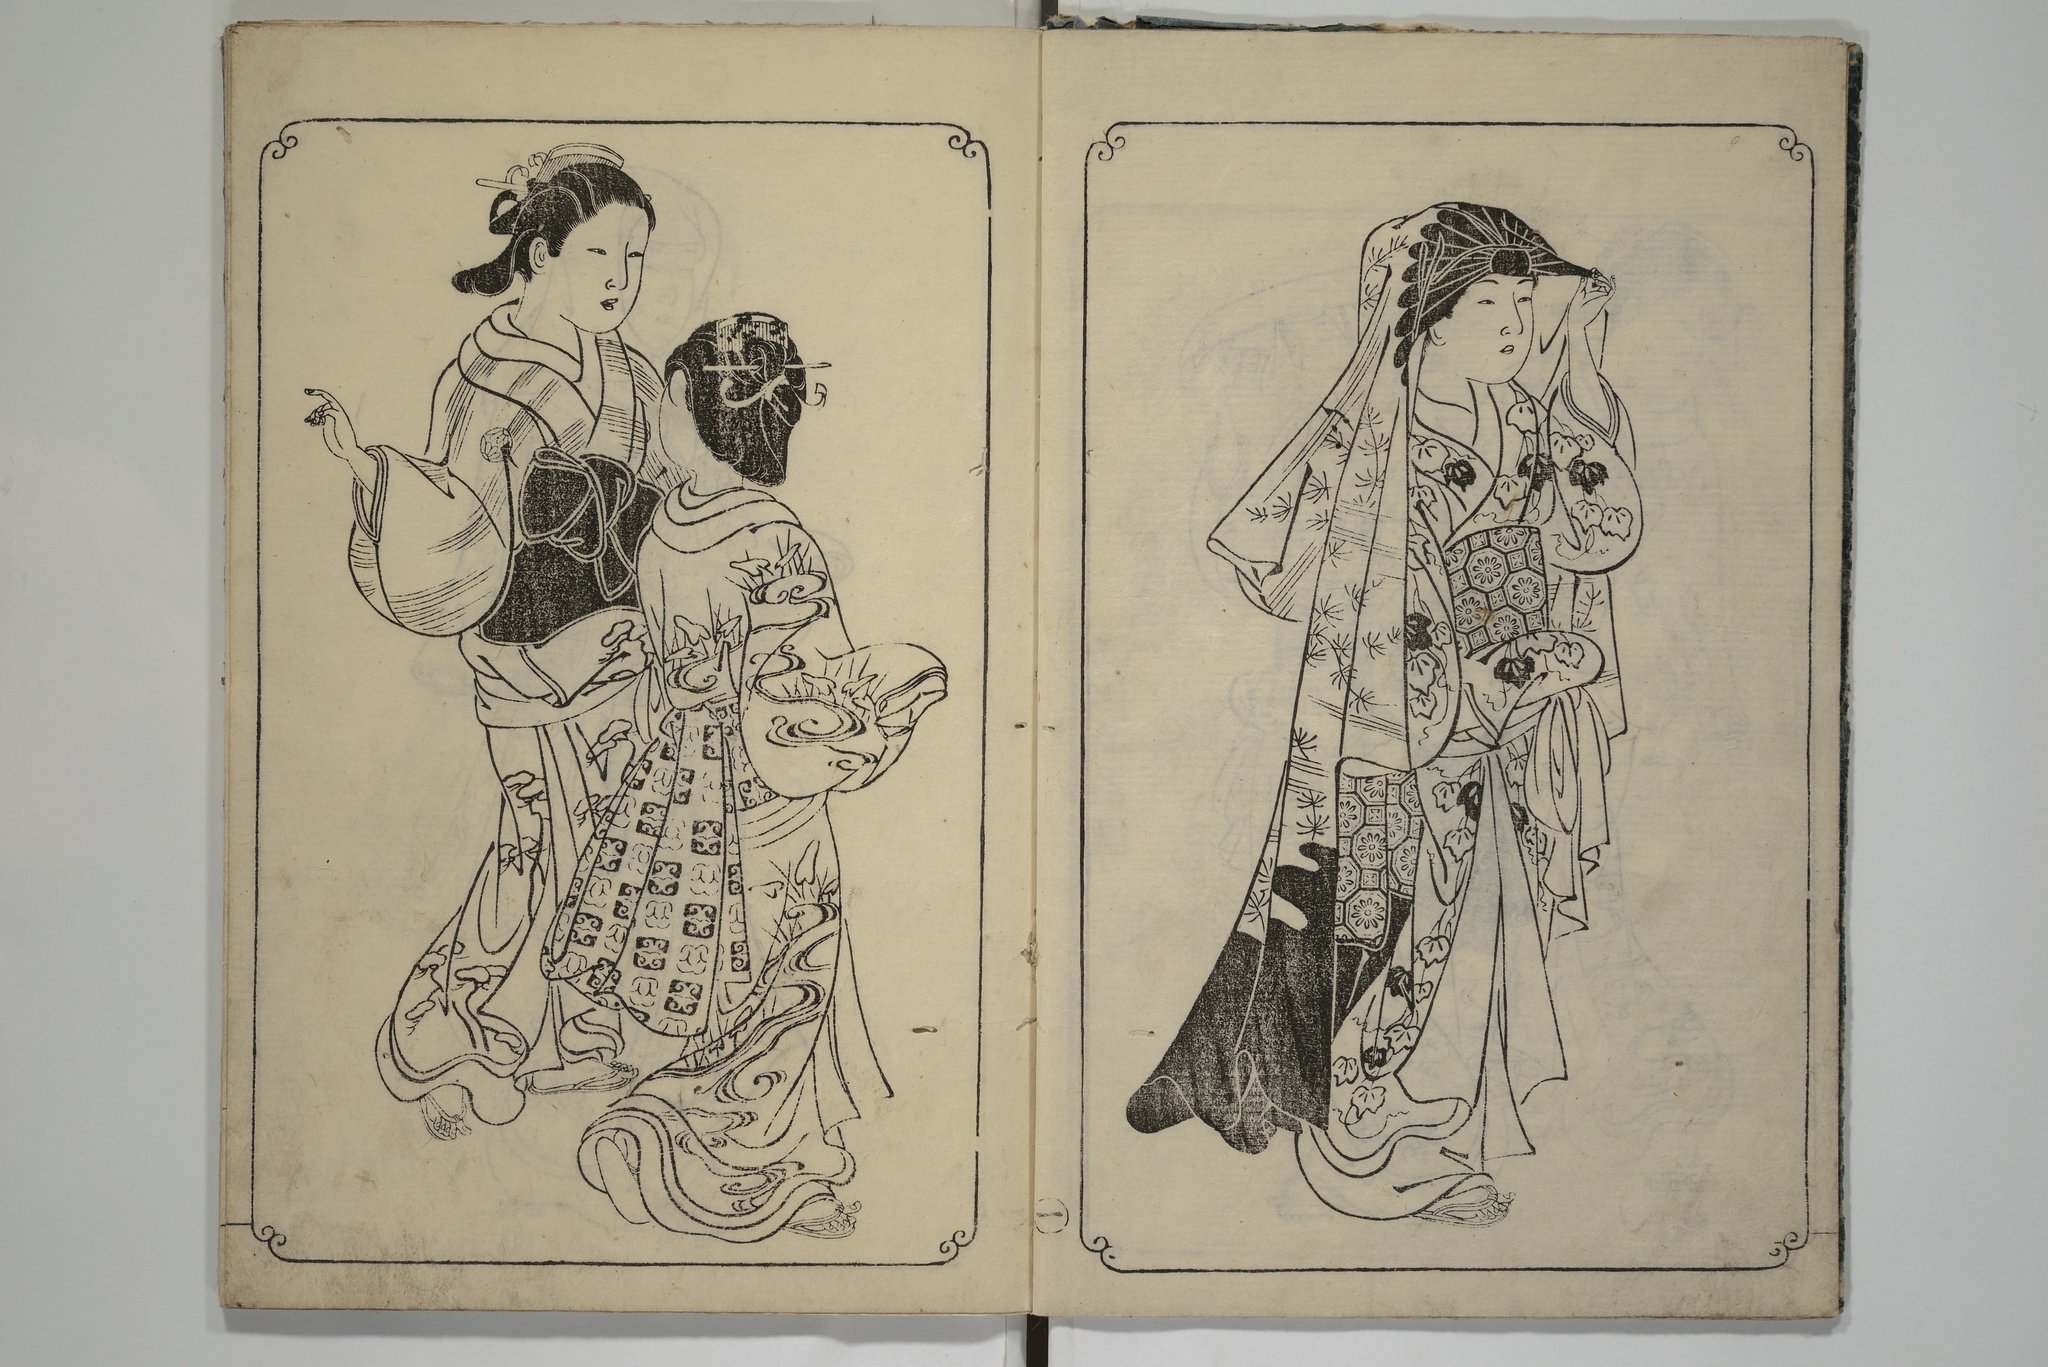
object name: illustrated book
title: Picture Book of Mount Asaka (Ehon asakayama) 絵本浅香山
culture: japanese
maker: nishikawa sukenobu 西川祐信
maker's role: artist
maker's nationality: japanese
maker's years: 1671-1750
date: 1739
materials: ink, paper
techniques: woodblock print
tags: women